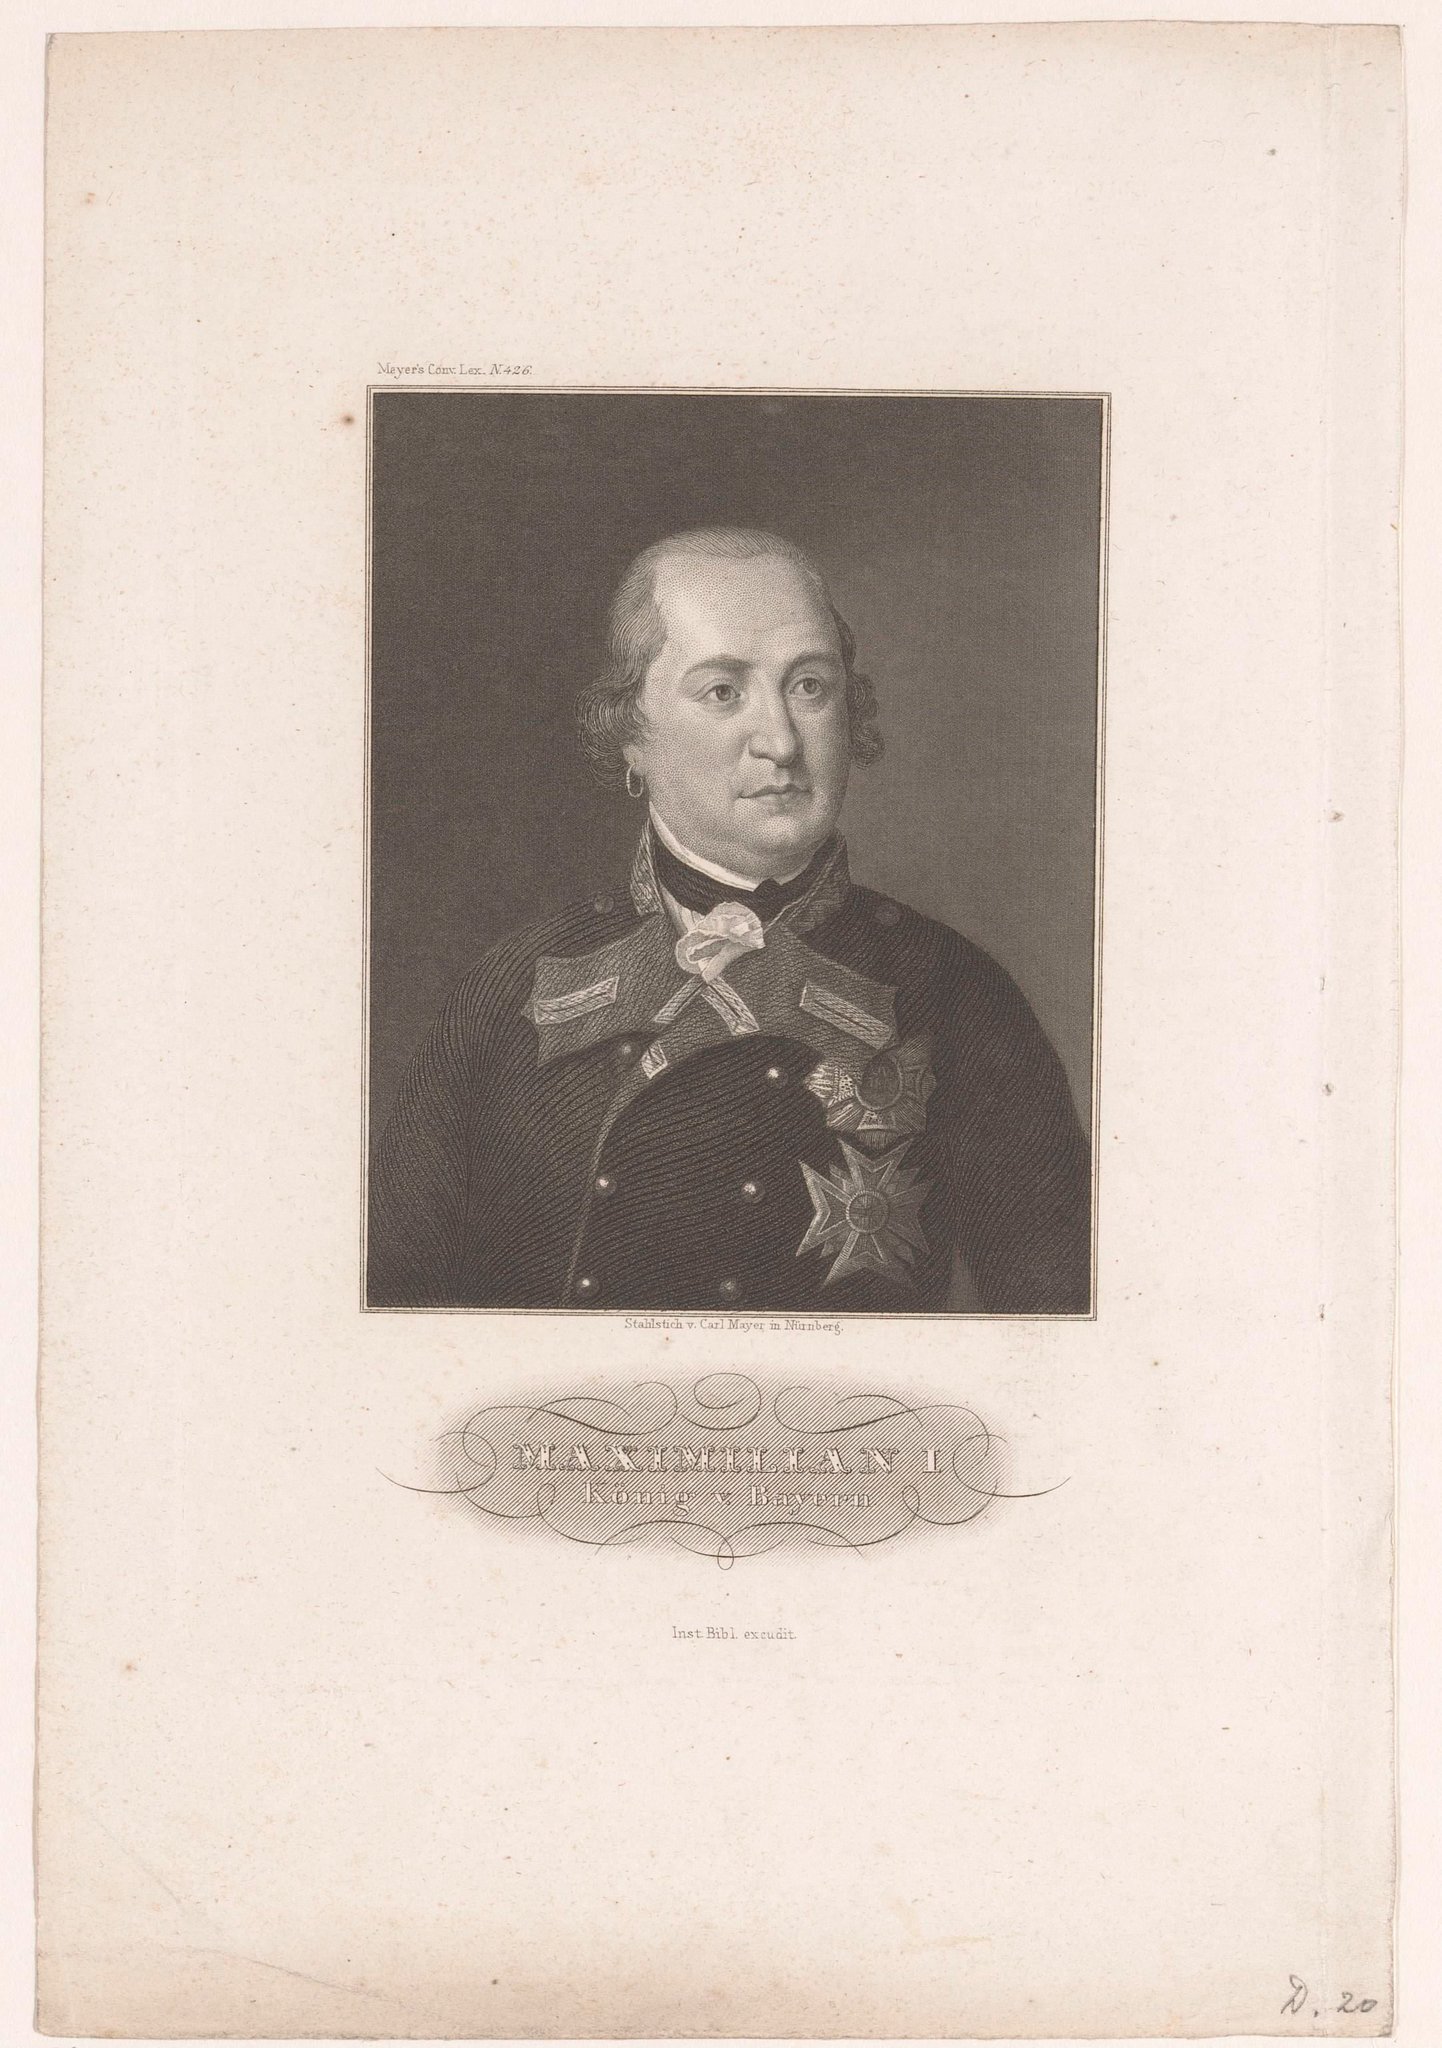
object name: book illustration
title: Portret van Maximilian I Jozef, koning van Beieren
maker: carl mayer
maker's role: print maker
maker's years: 1798-1868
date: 1840-1855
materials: paper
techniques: engraving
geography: hildburghausen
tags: maximiliaan i jozef (koning van beieren), knighthood order, historical persons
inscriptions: collector's mark: Lugt 2228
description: Prent afkomstig uit: Conversations-Lexikon für die gebildeten Stände, voor het eerst uitgegeven tussen 1840-1855.